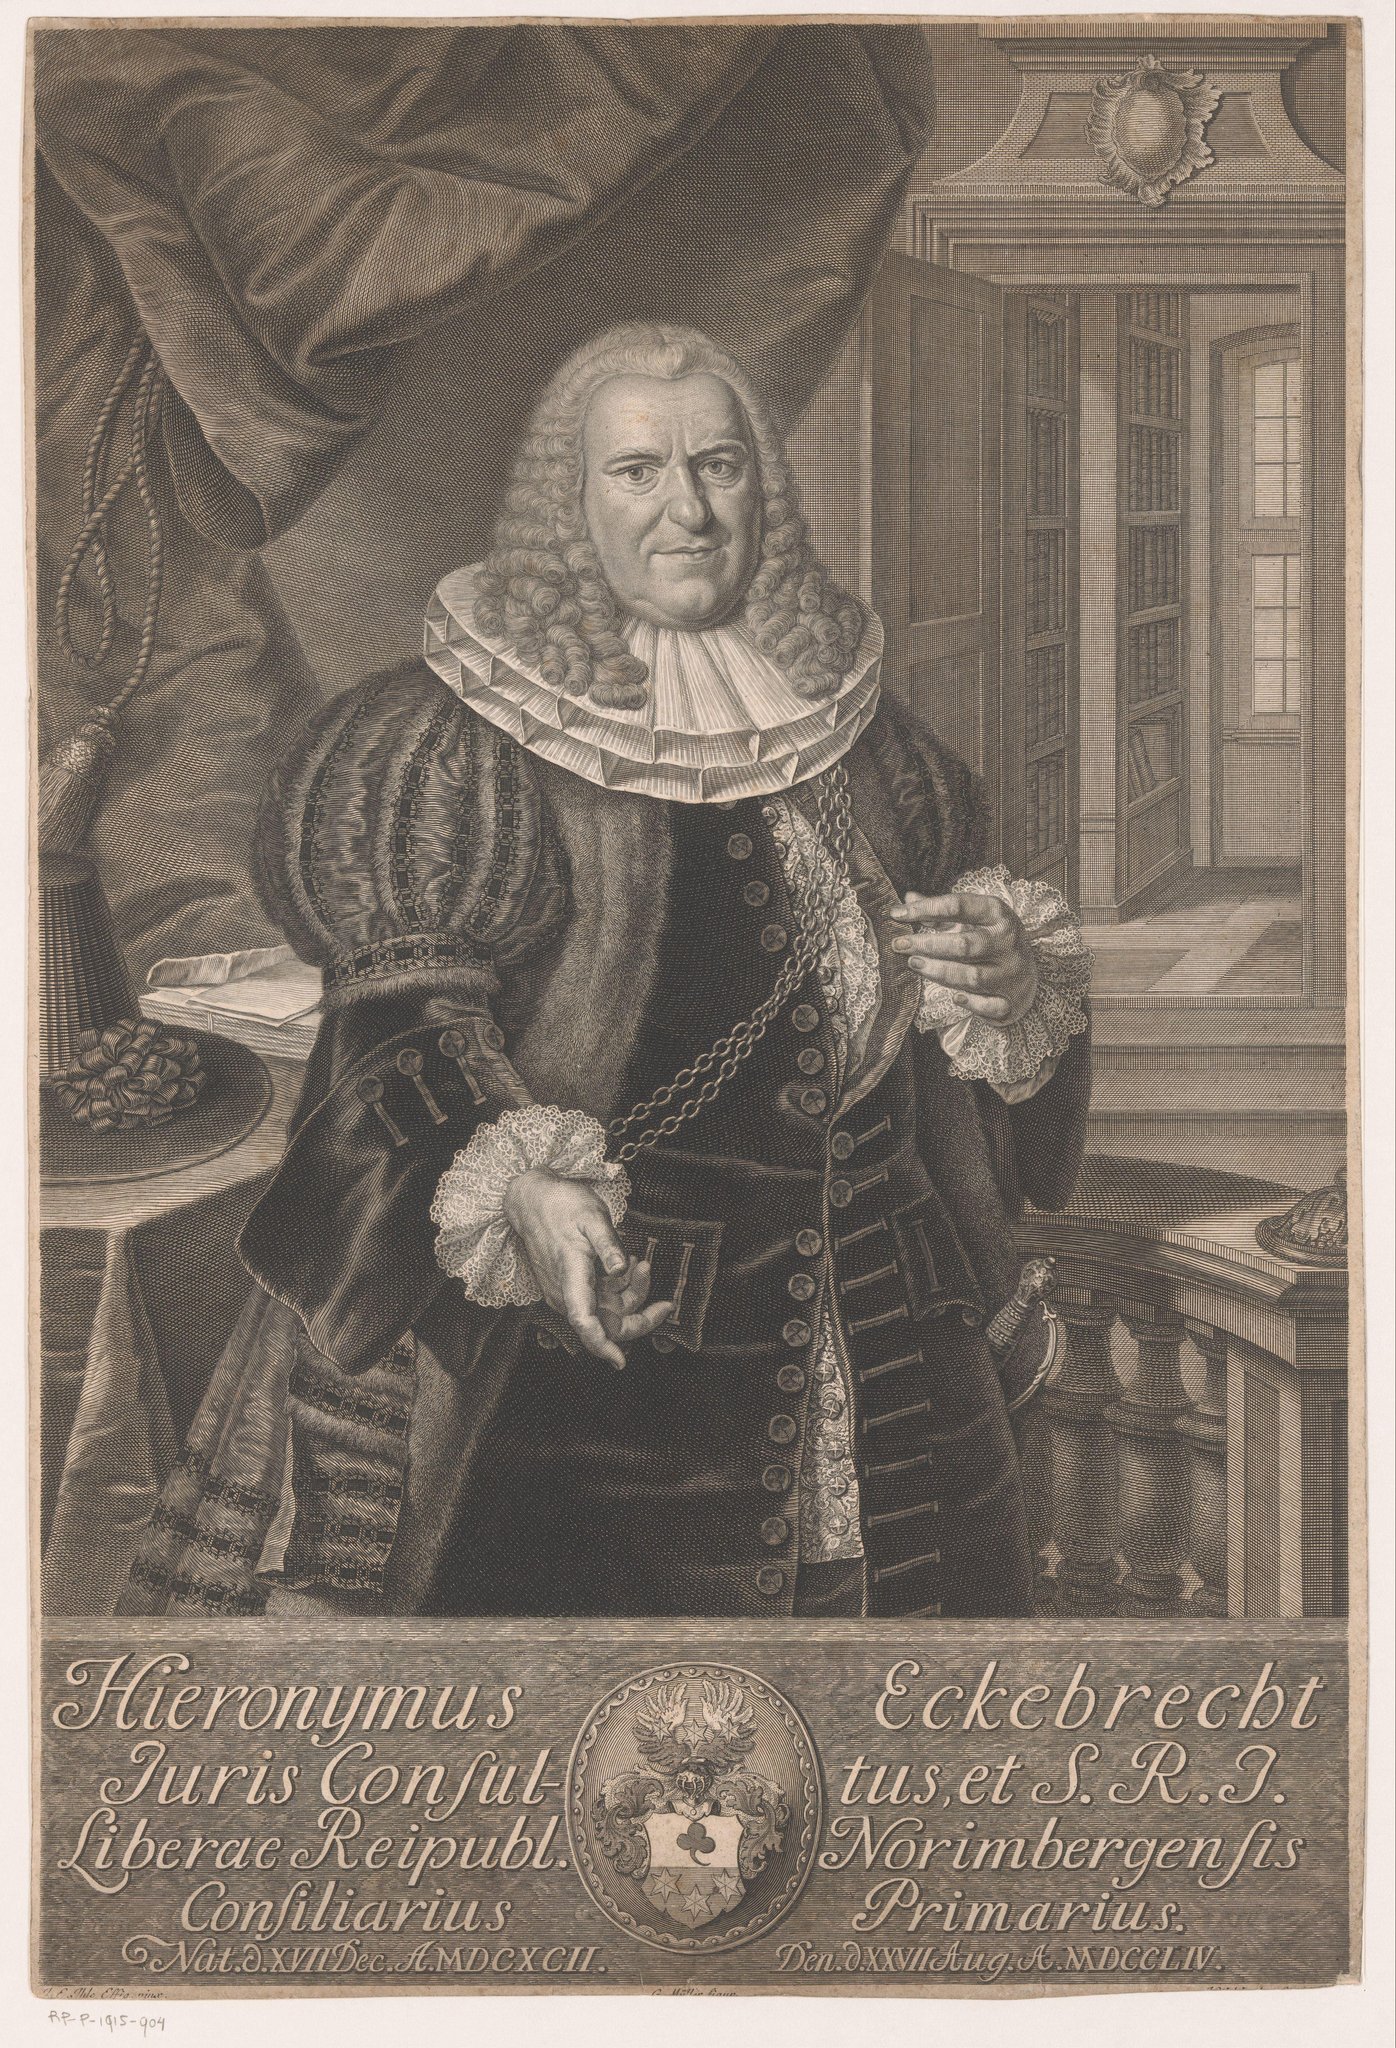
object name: print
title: Portret van Johann Heinrich Philipp Höltzel von Sternstein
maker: johann wilhelm windter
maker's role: draughtsman, print maker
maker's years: 1696-1765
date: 1750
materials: paper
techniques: engraving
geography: nuremberg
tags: historical persons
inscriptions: collector's mark: Lugt 2228